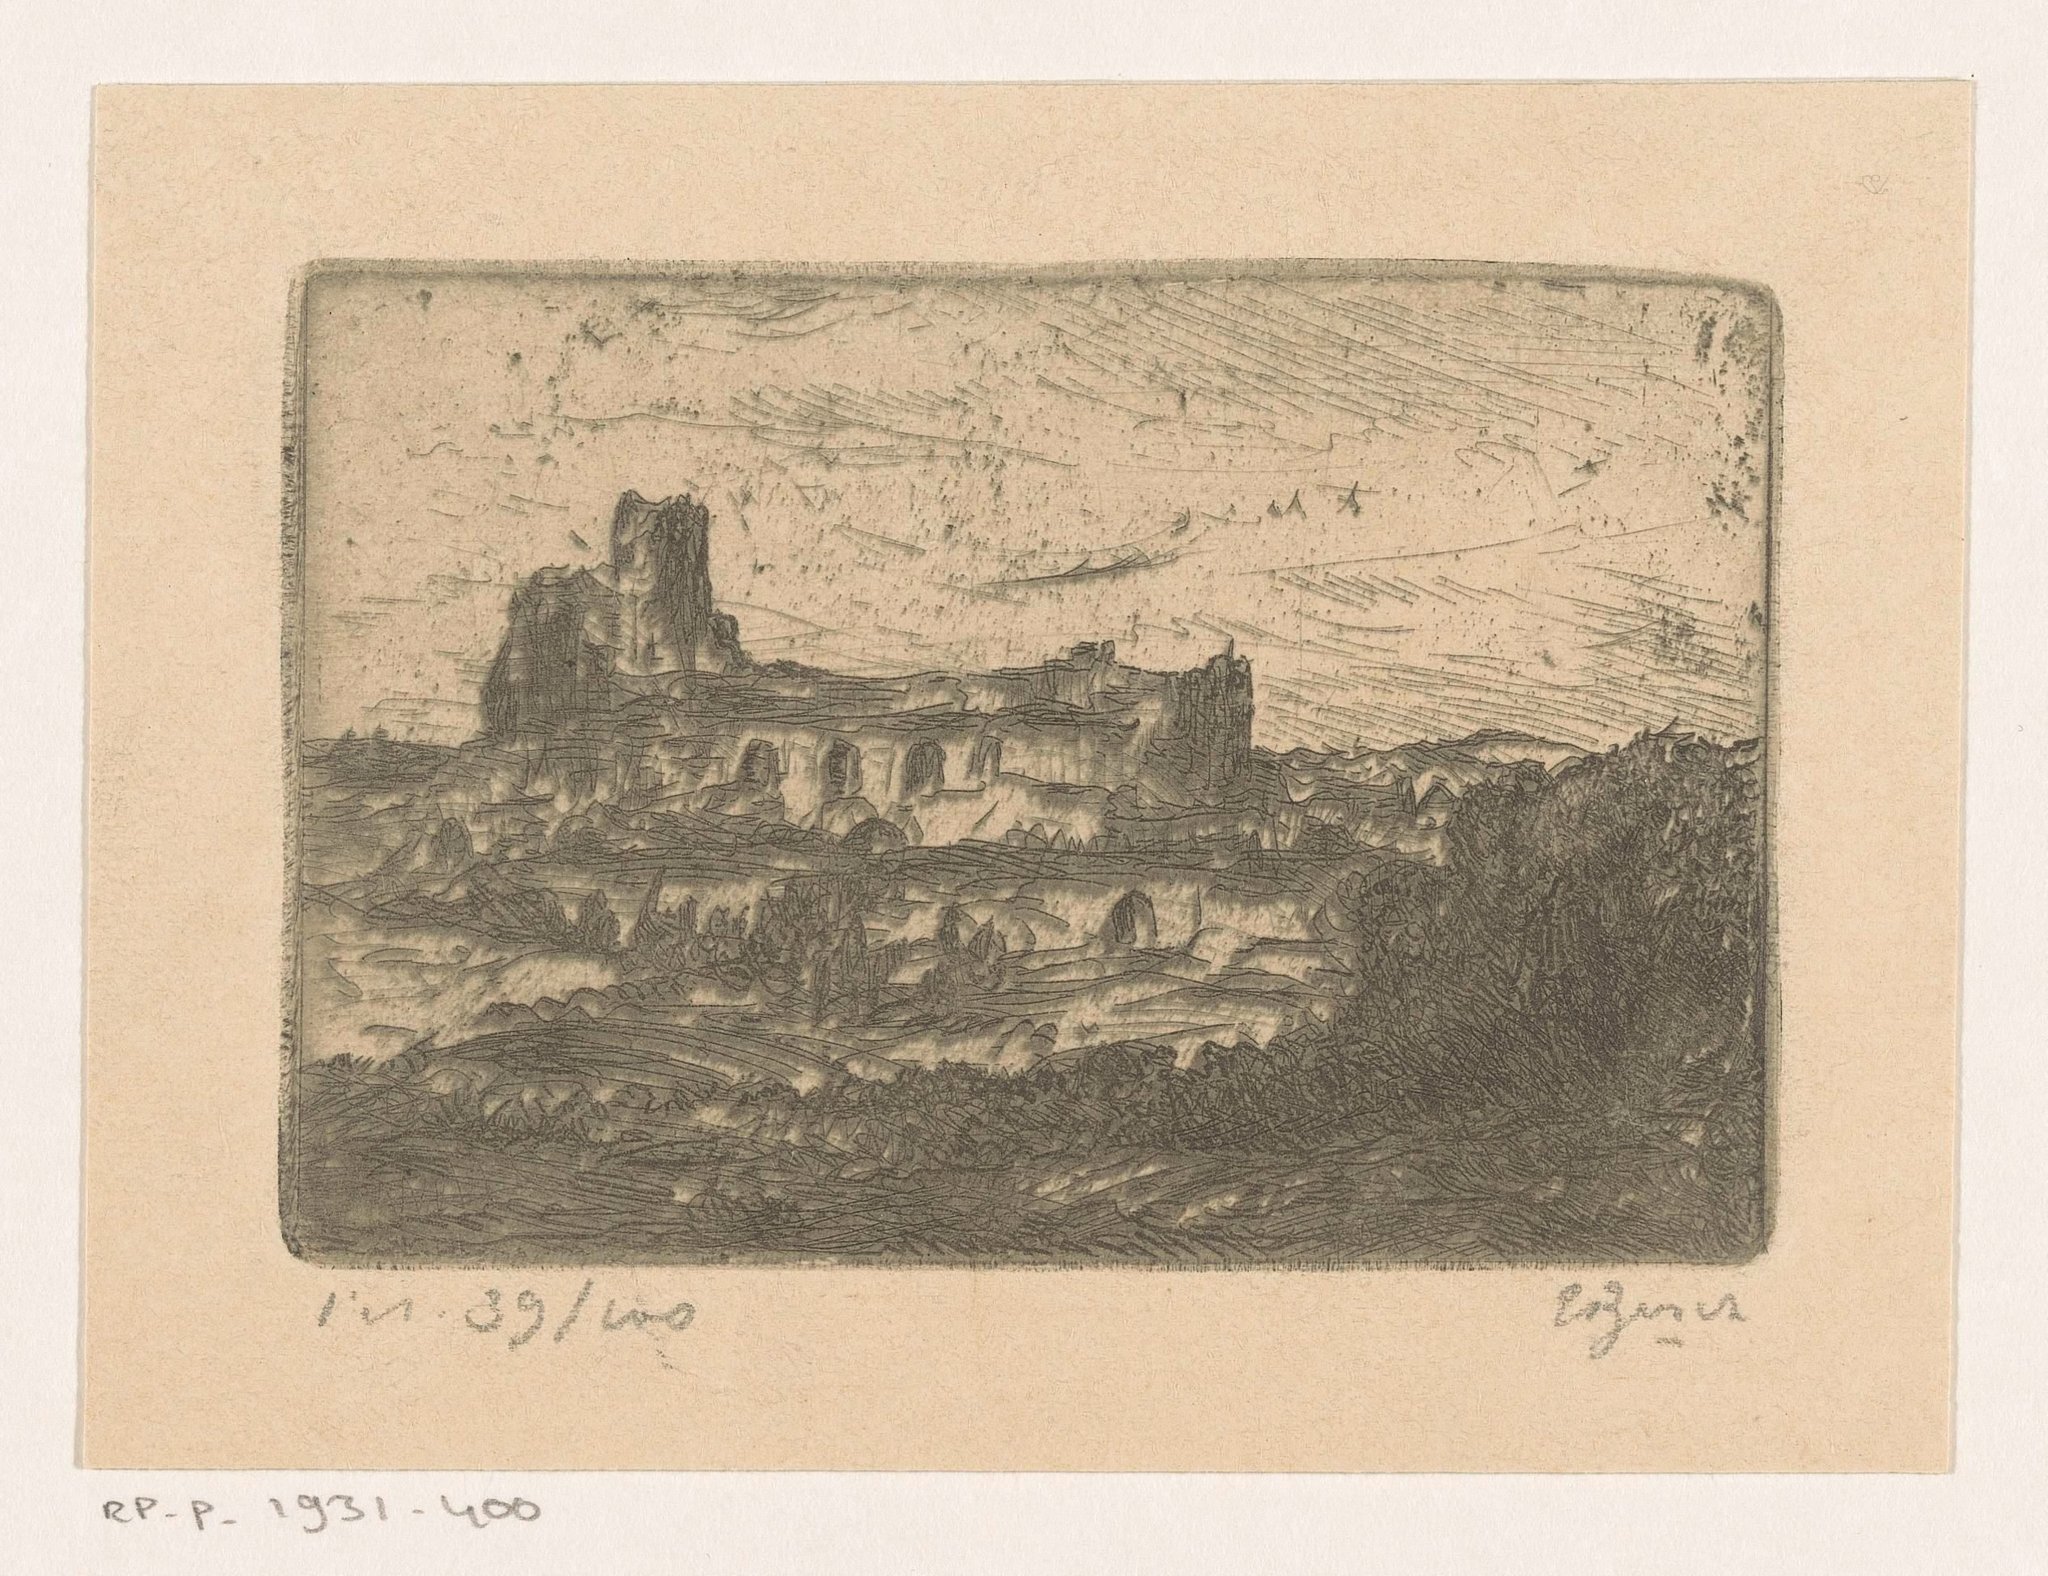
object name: print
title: Ruïne Rome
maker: etienne bosch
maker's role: print maker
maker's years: 1863-1933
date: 1873-1931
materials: paper, ink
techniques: drypoint, etching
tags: landscape with ruins, rome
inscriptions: signature: ‘EBosch’, collector's mark: Lugt 2228, edition: ‘1e et. 39/100’, title: ‘Ruins a Rome’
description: Gezicht op een ruïne met rechtsvoor struiken in silhouet.